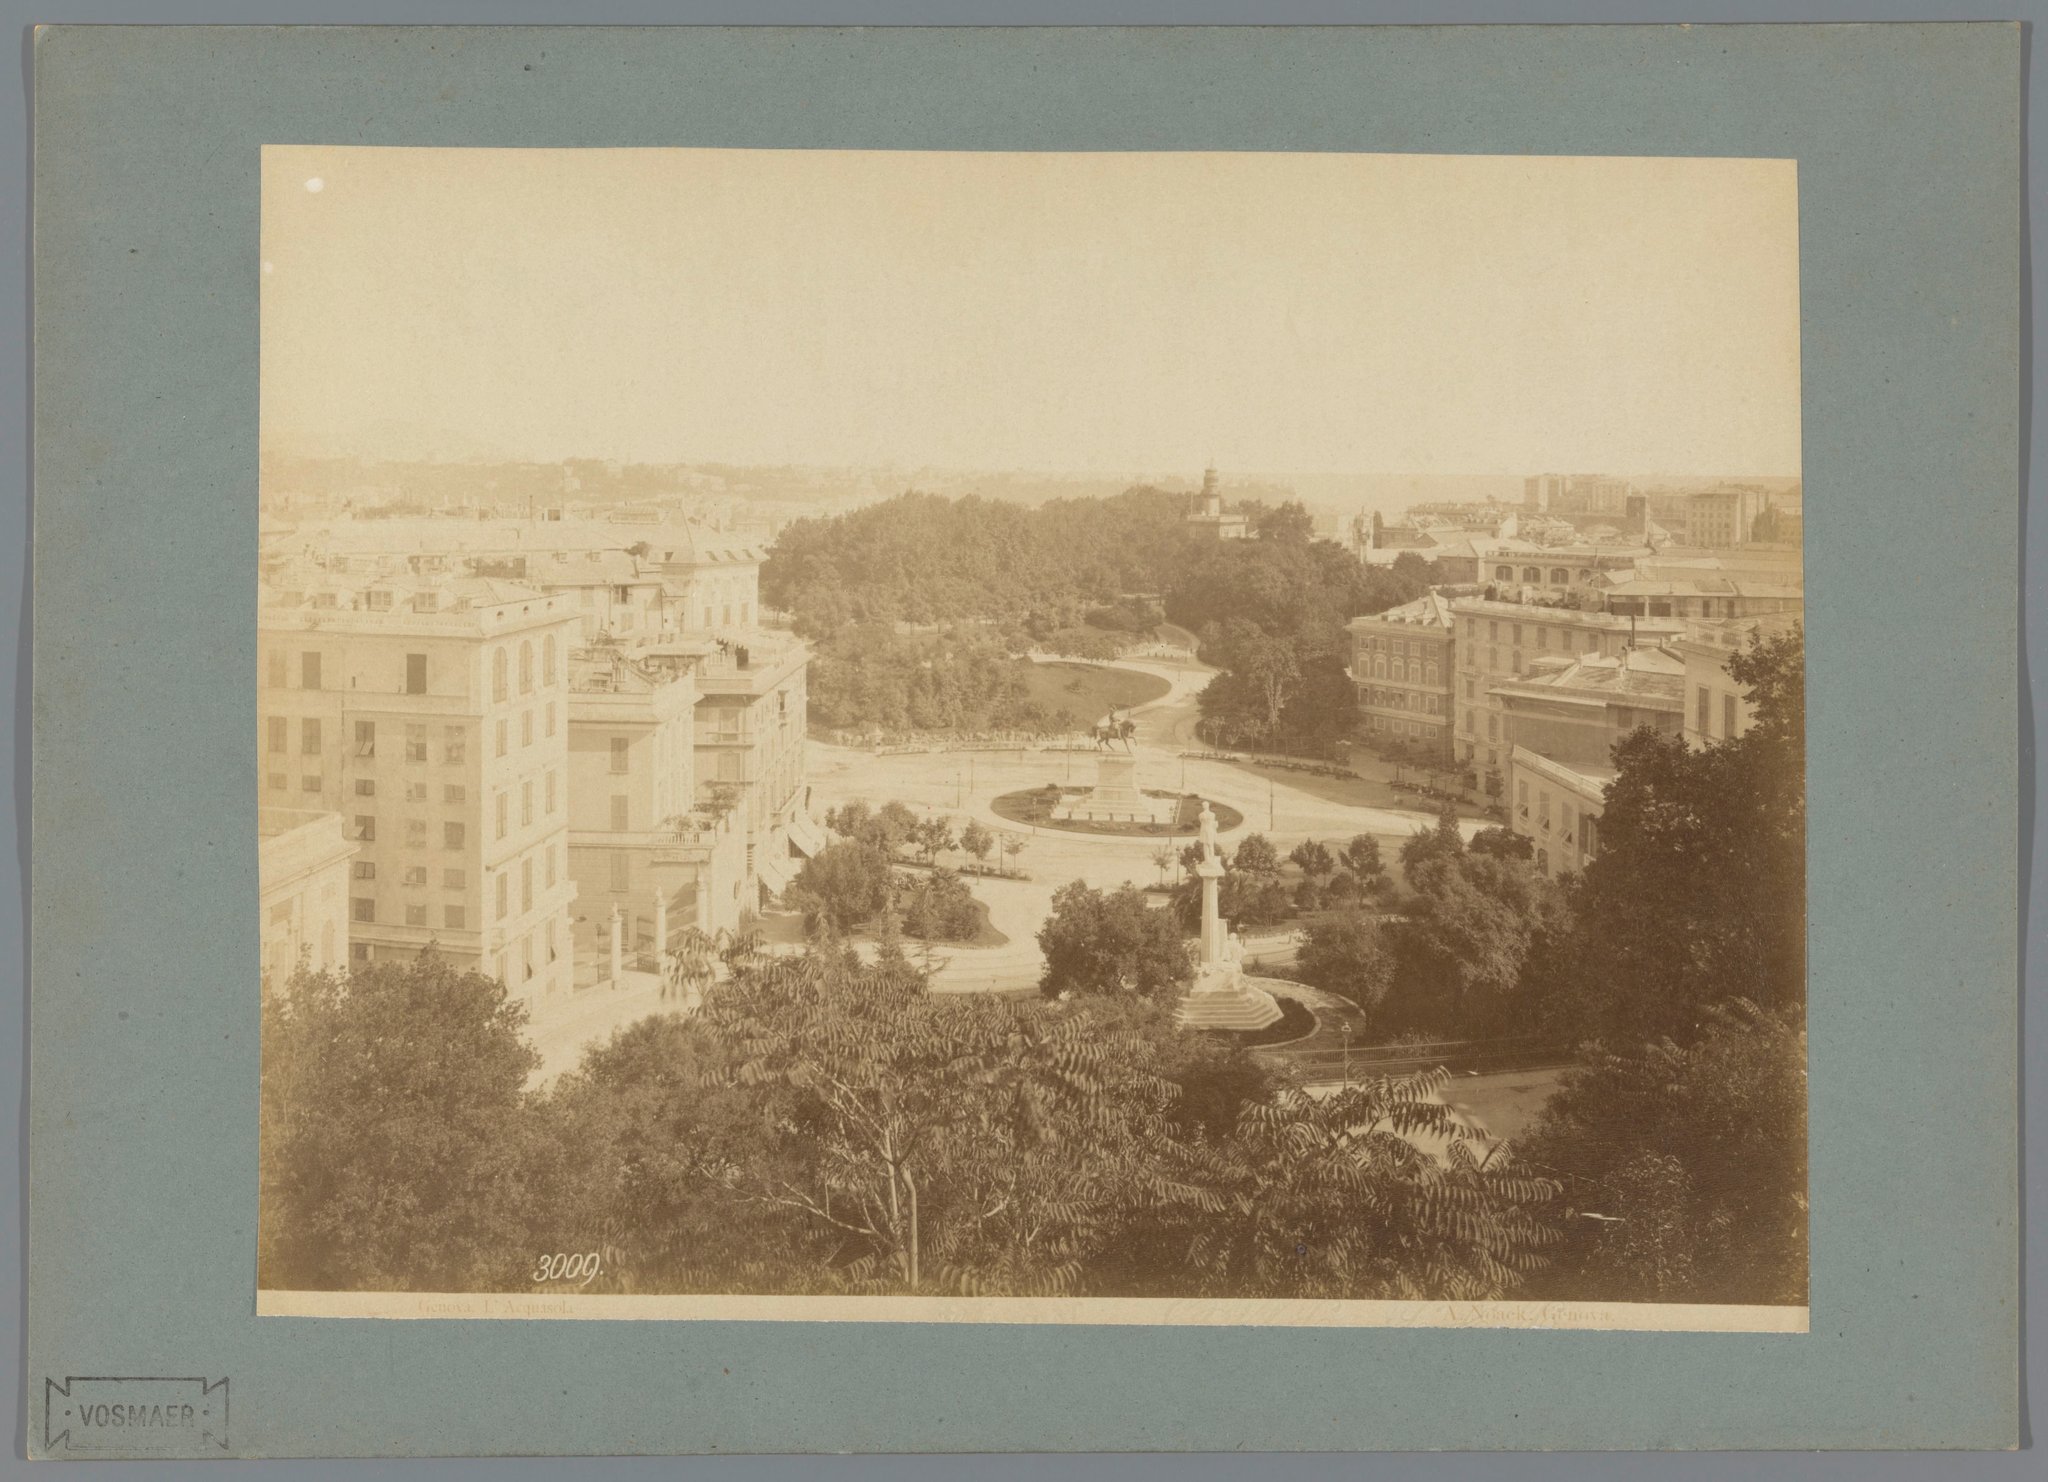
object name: photograph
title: Gezicht op het Parco dell'Acquasola te Genua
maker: alfredo noack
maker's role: fotograaf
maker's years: 1833-1895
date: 1858-1893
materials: cardboard, paper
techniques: albumen print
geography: genoa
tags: square, place, circus, etc., prospect of city, town panorama, silhouette of city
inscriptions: number: ‘3009.’, collector's mark: ‘VOSMAER’